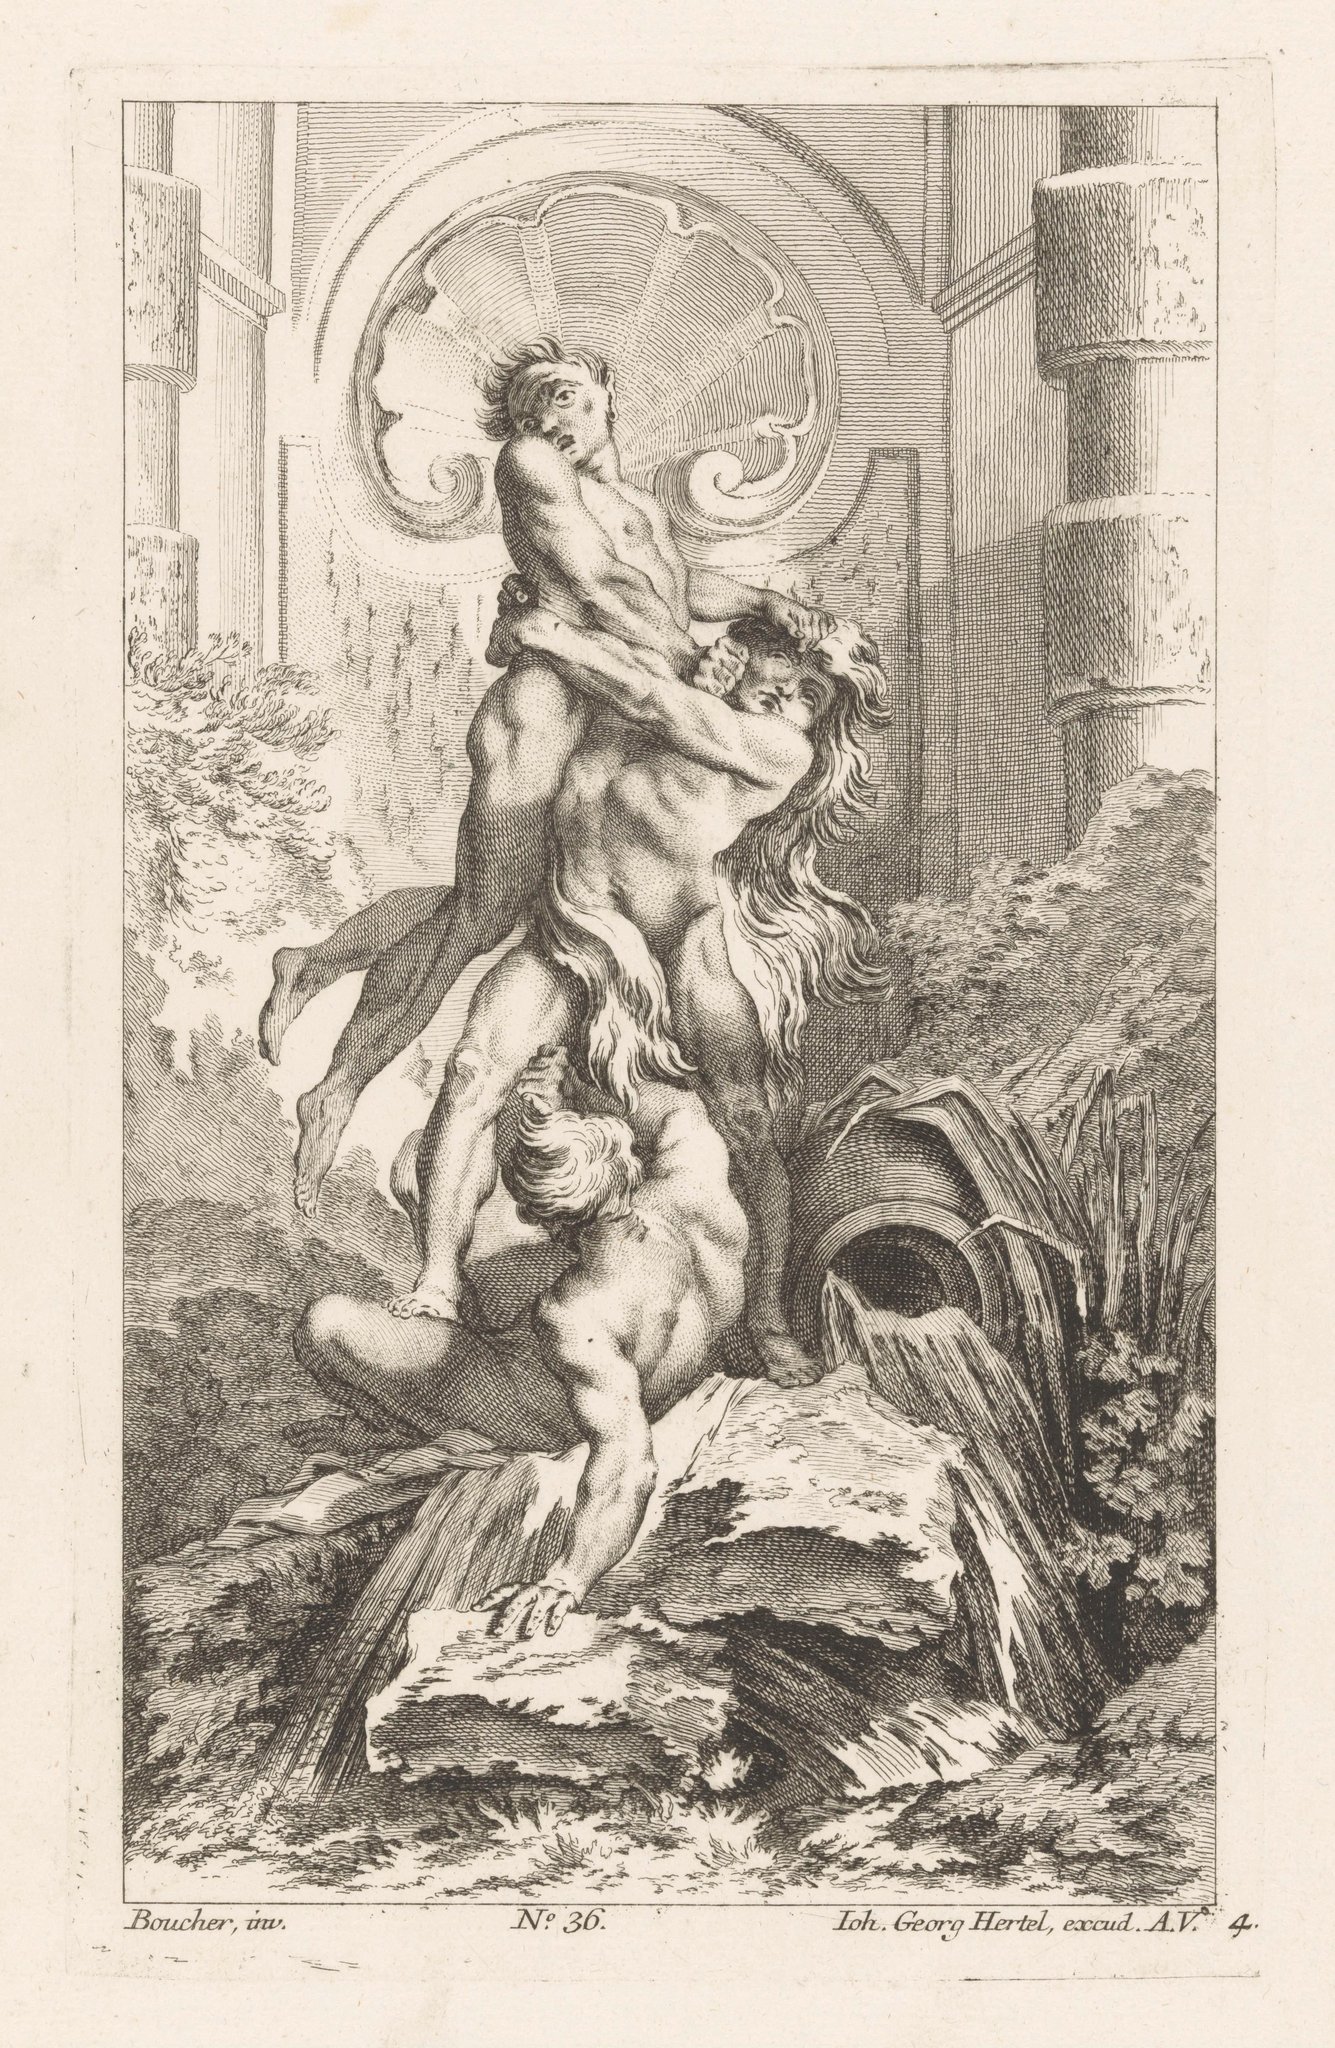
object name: ornament print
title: Diverses Fontaines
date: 1713-1760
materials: paper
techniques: etching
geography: augsburg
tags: being carried, ornamental fountain, lying figure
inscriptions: collector's mark: Lugt 2228, collector's mark: Lugt 2760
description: Een man met lang haar tilt een jongeman omhoog. Aan hun voeten ligt een derde man naast een kruik waar water uit stroomt. Uitgeversnummer 36.